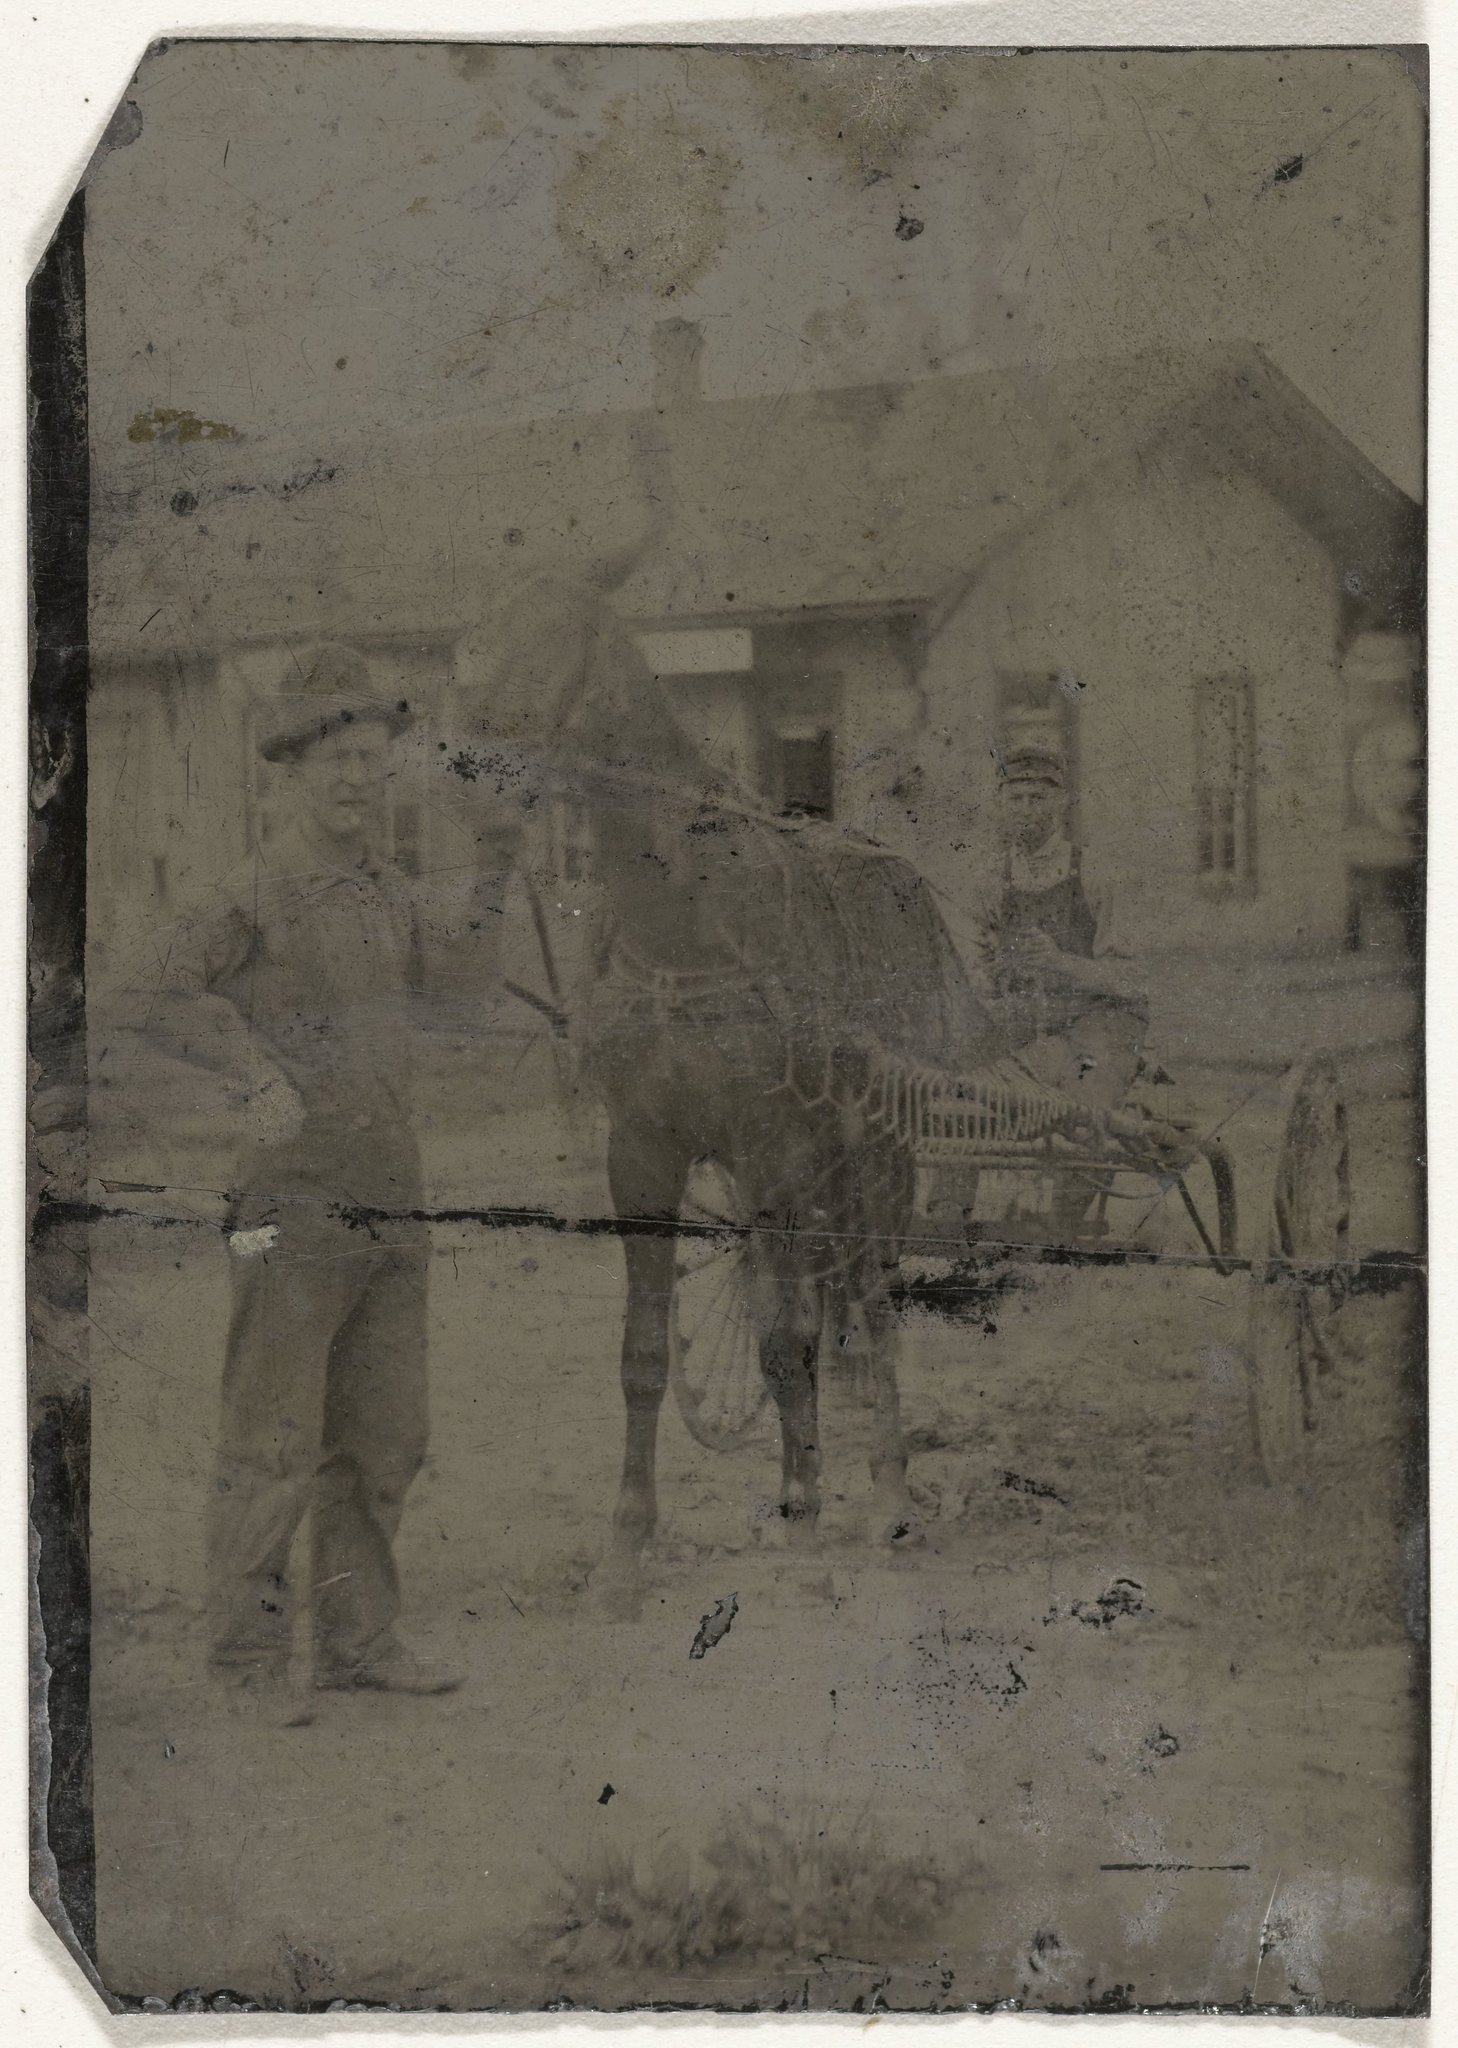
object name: photograph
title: Twee mannen, een paard en een kar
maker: Anonymous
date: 1880-1910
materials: metal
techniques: ferrotyping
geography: united states